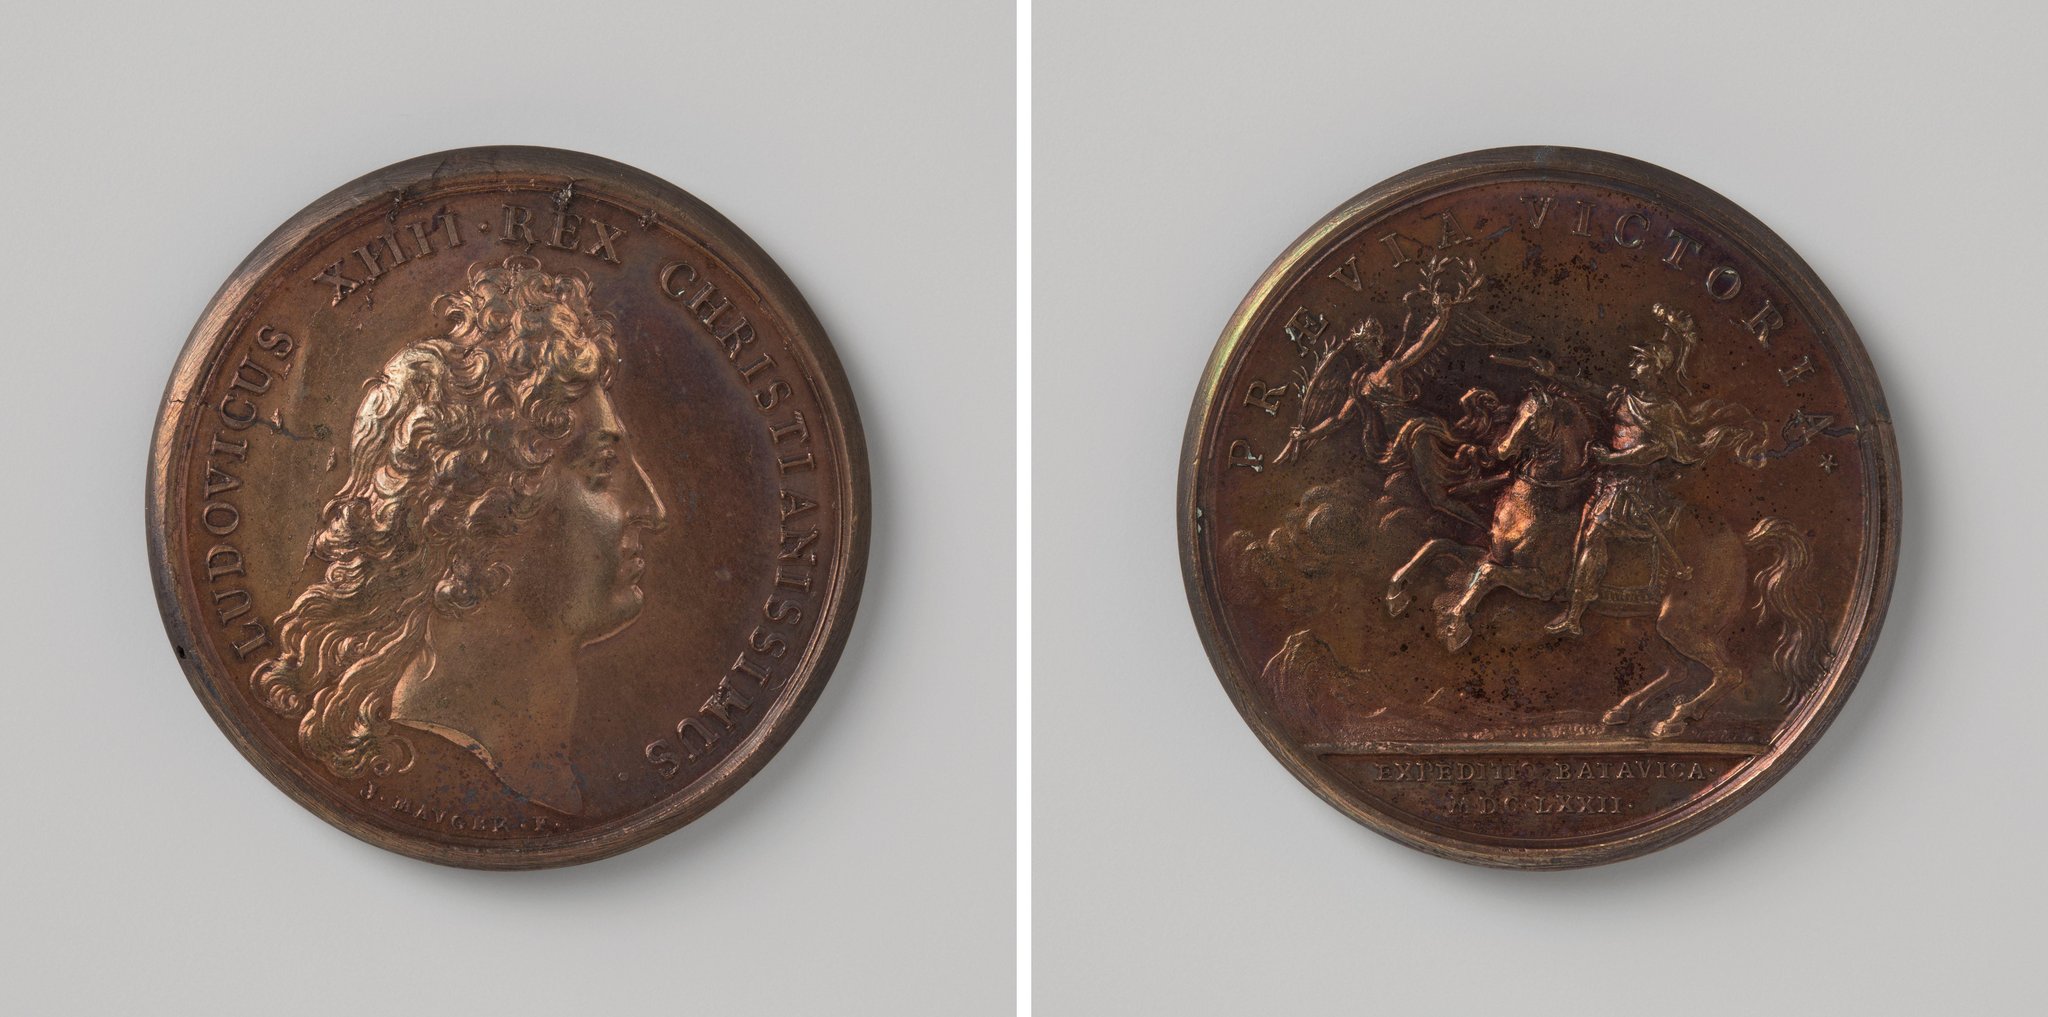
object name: history medal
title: Veldtocht van Lodewijk XIV in de Nederlanden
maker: jean mauger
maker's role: medailleur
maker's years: 1648-1722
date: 1699-1703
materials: bronze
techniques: striking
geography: paris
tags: lodewijk xiv (koning van frankrijk), low countries, rampjaar (disaster year)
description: Bronzen penning. Voorzijde: borststuk jongeman (Lodewijk XIV) binnen omschrift. Keerzijde: koning te paard met commandostaf begeleid door Overwinning met palmtak en lauwerkrans binnen omschrift.